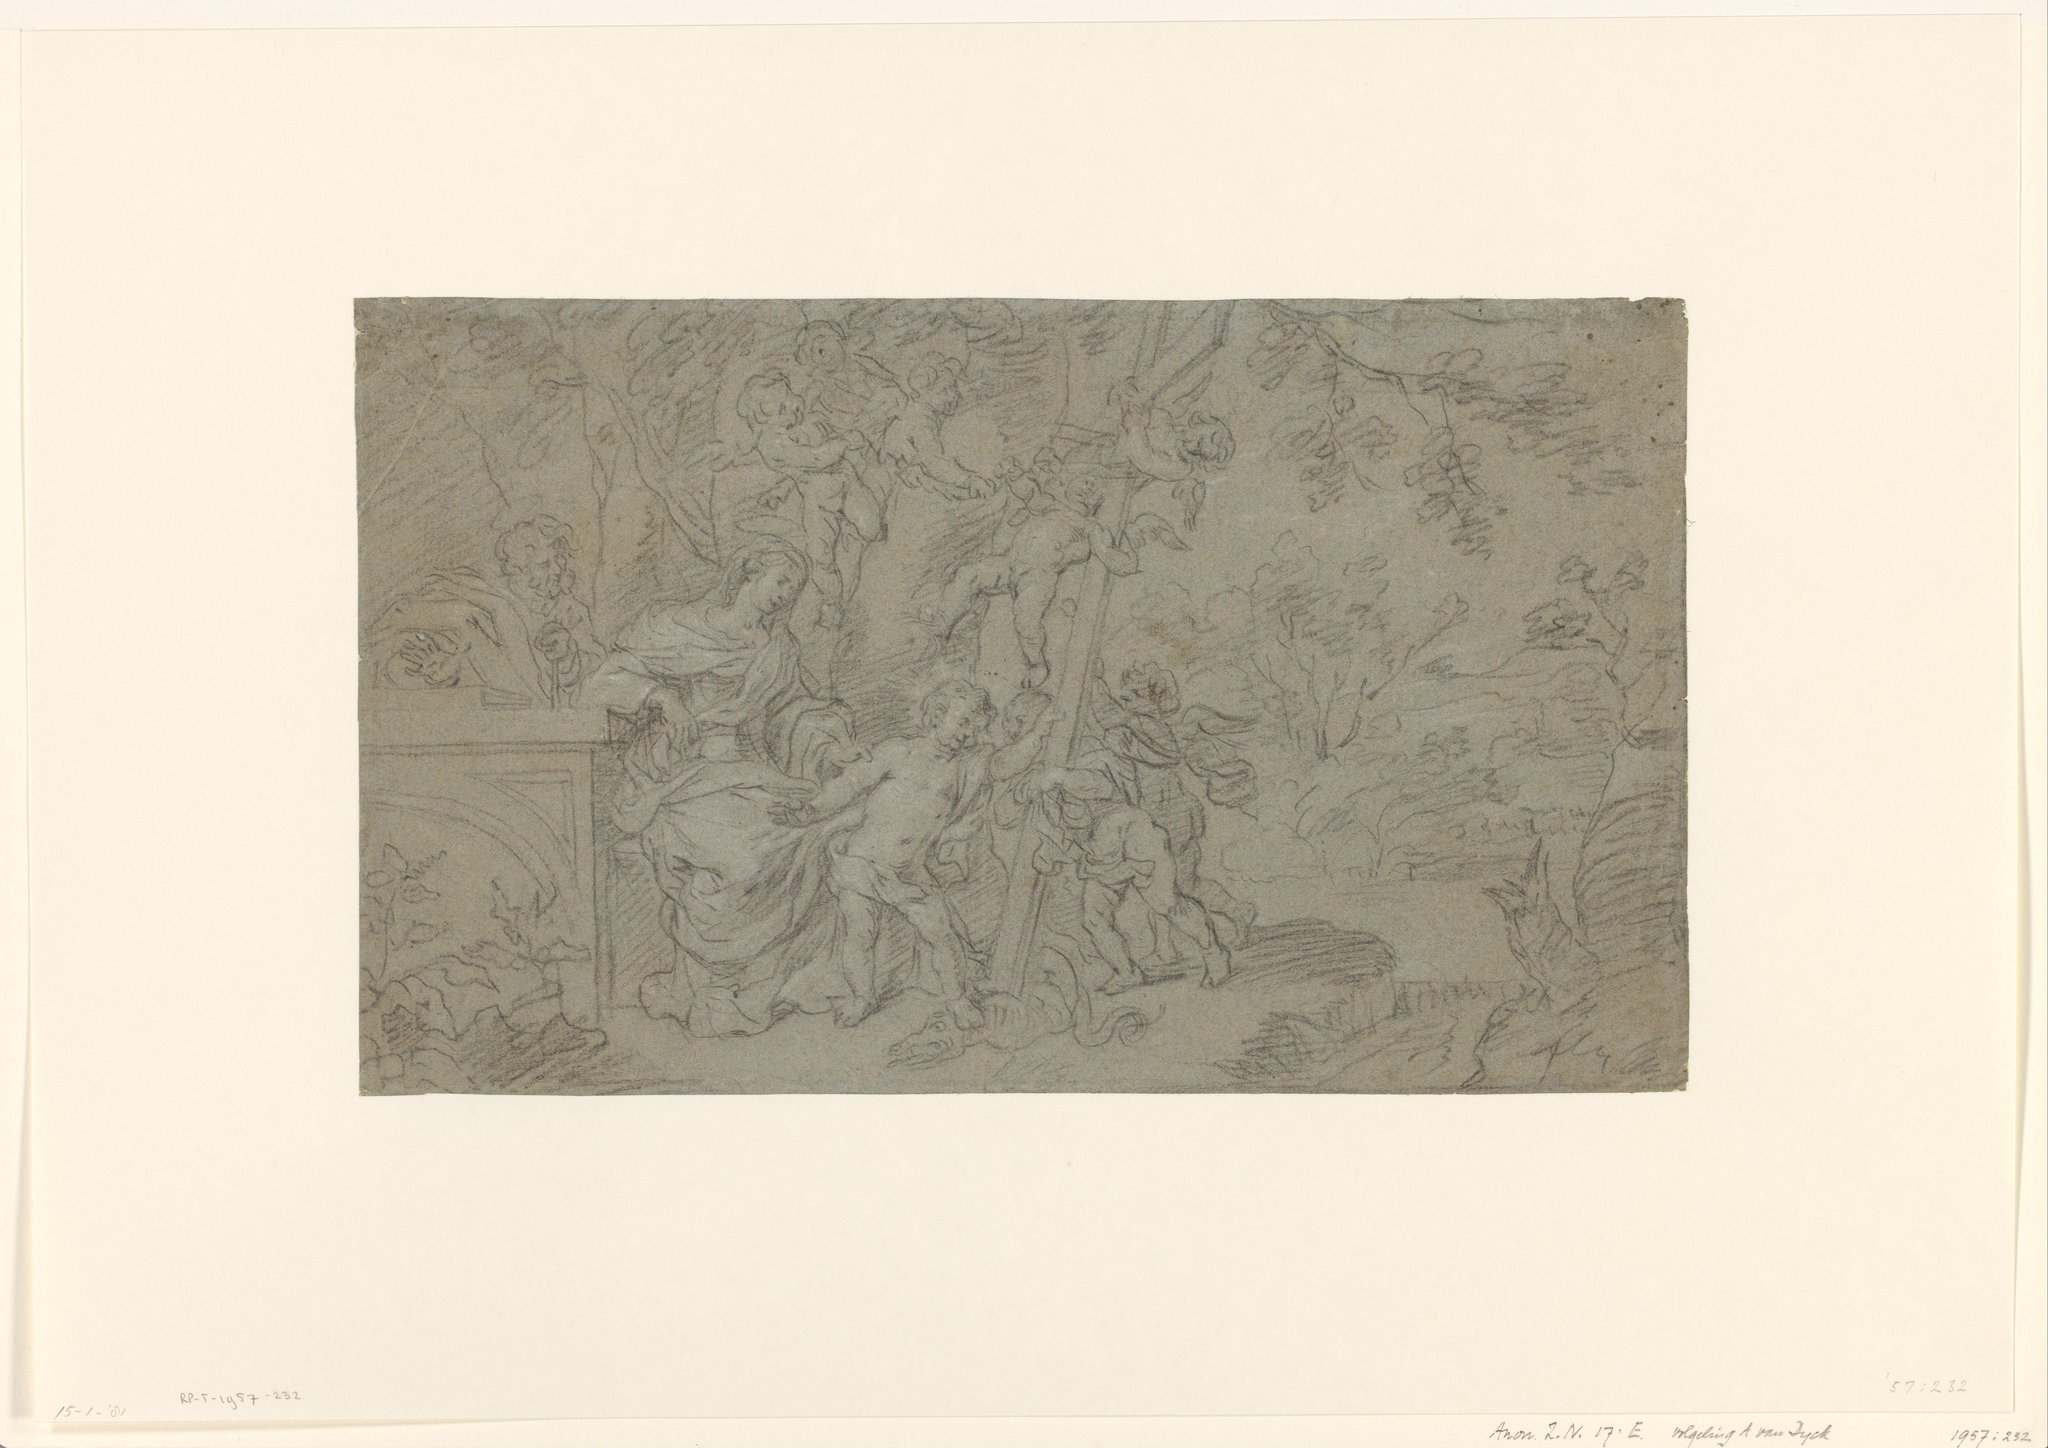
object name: drawing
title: Heilige Familie in landschap met engelen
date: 1600-1699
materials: chalk, paper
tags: holy family with others, e.g.: anna, christ-child carrying the cross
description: Heilige Familie in landschap met engelen, die het kruis aandragen.